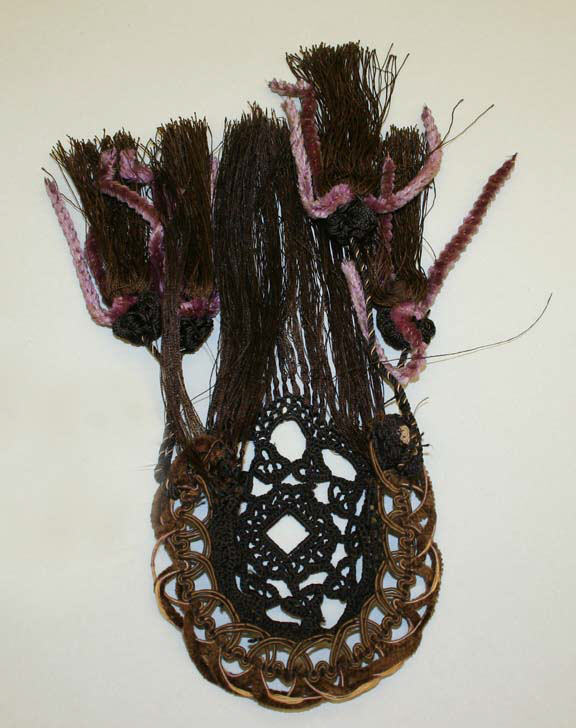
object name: headdress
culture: american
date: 1840-1850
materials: silk